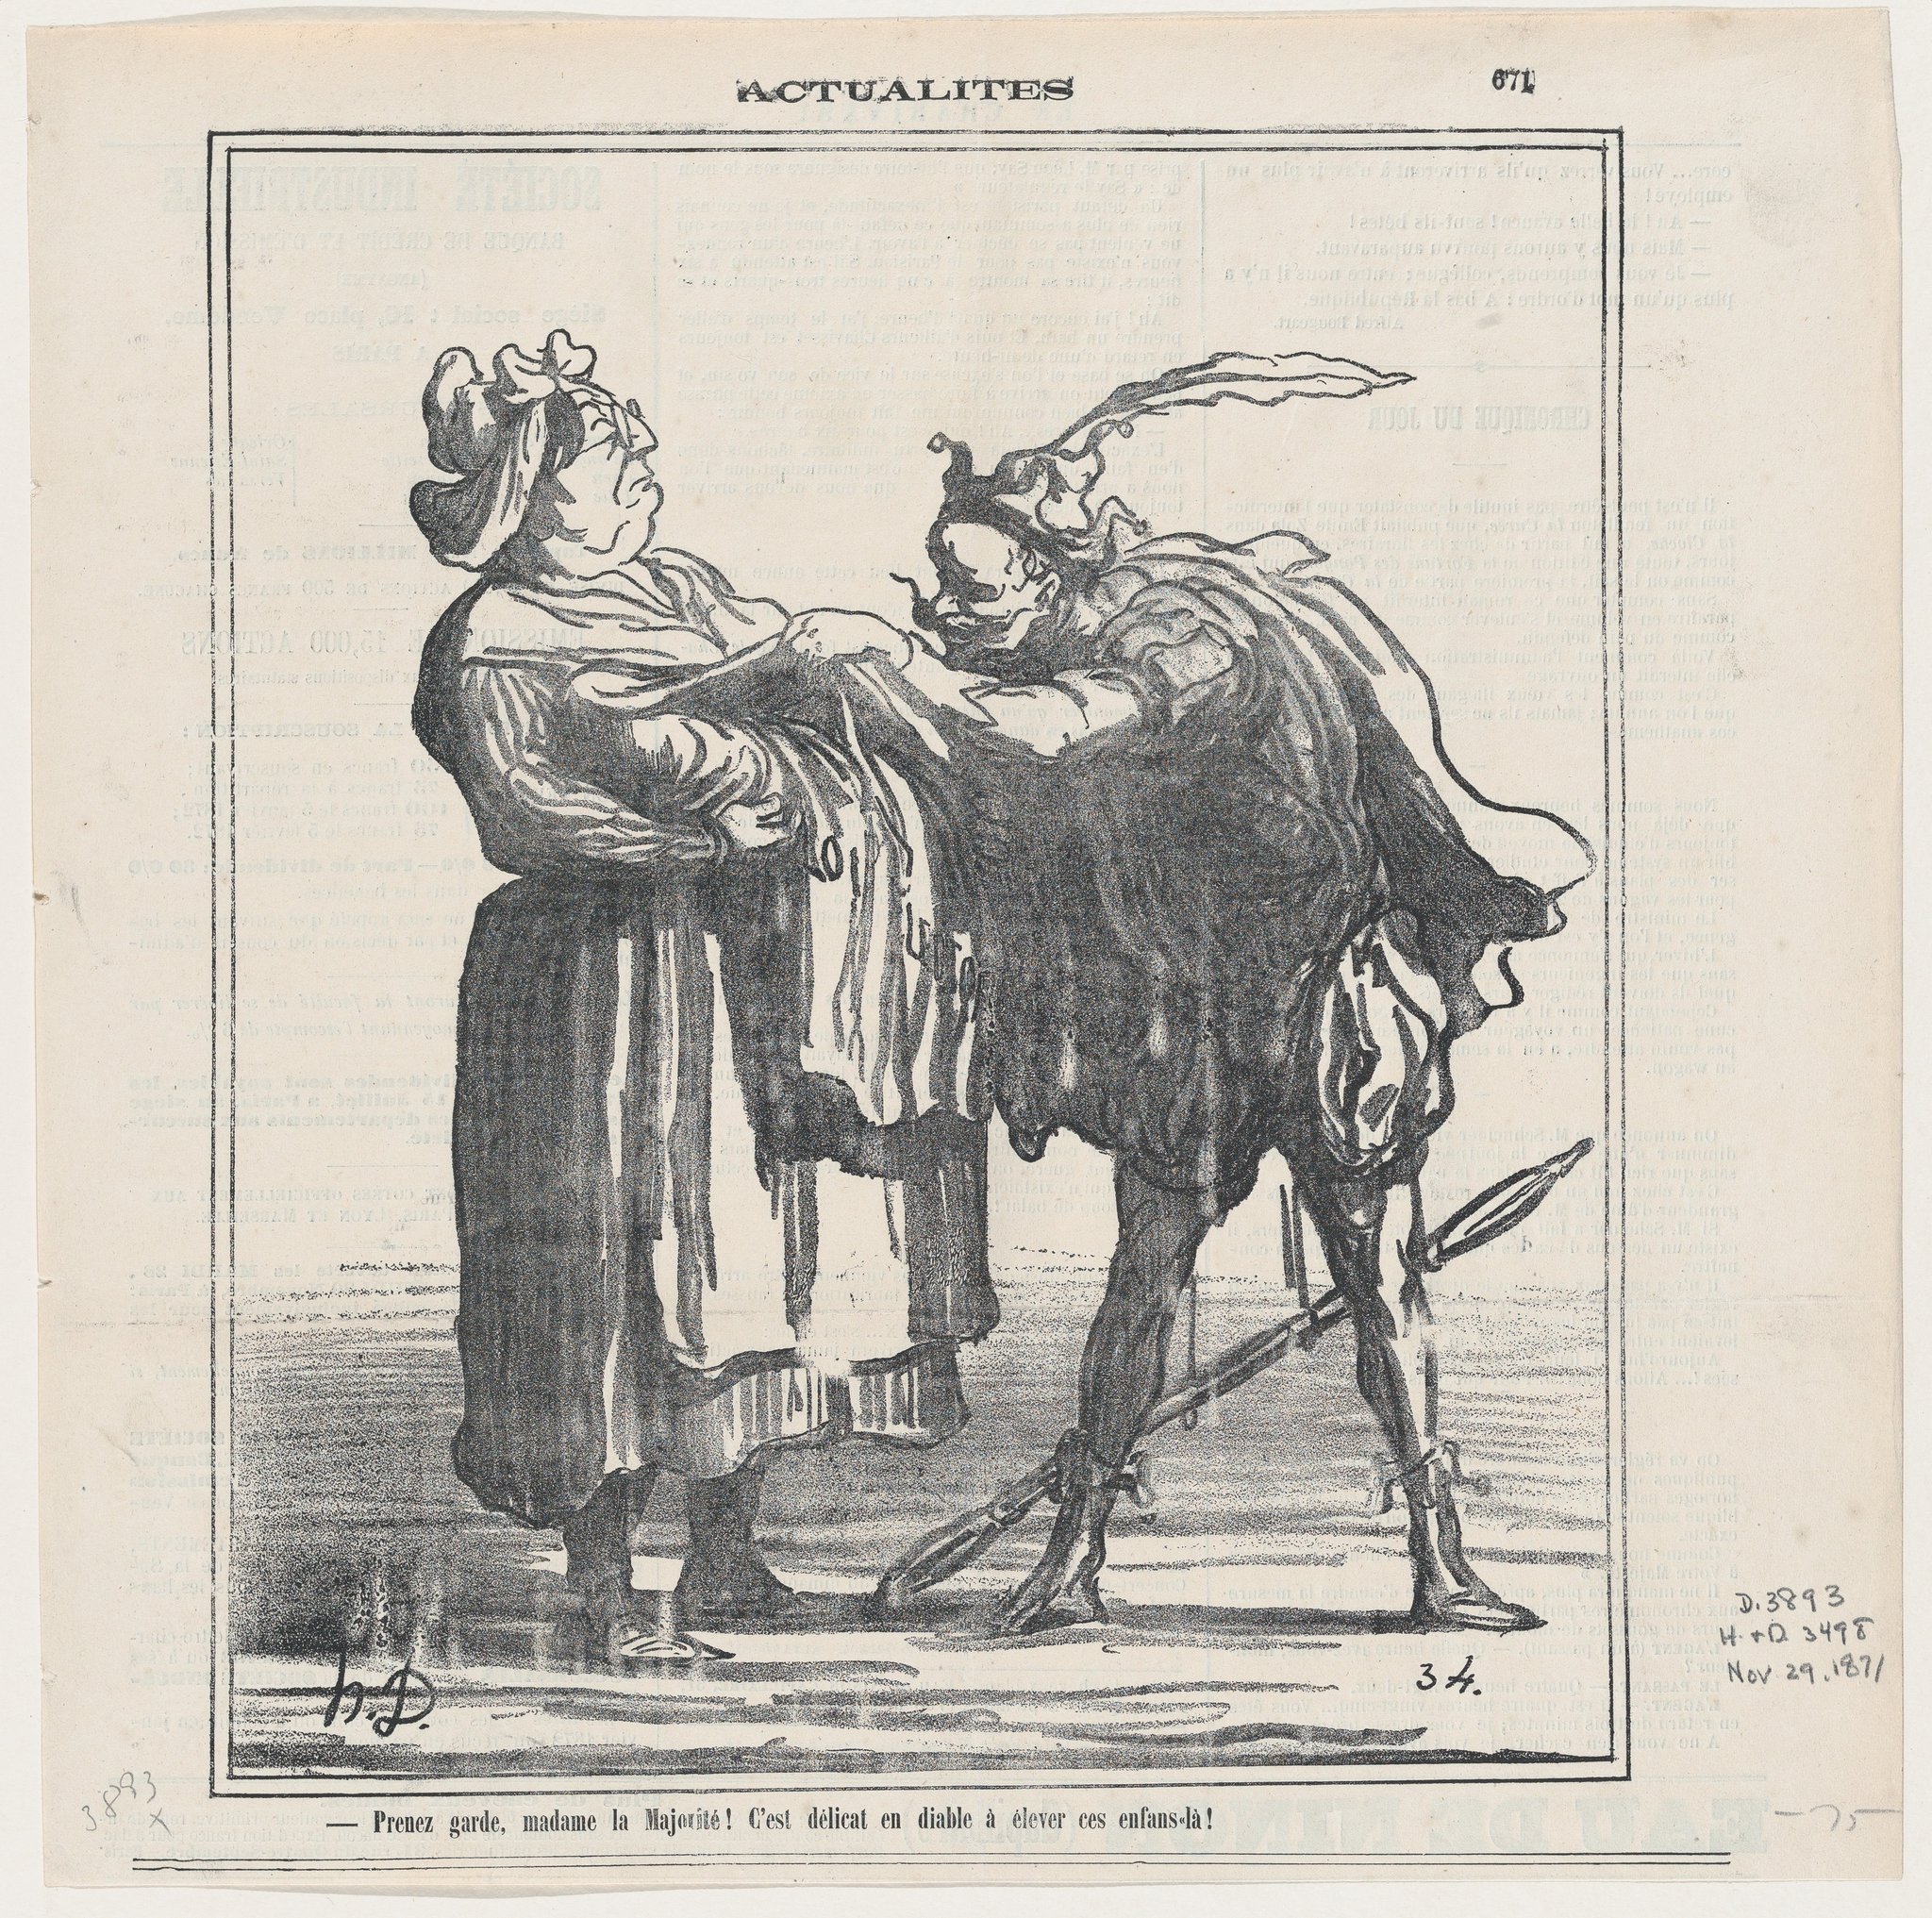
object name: print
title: Beware Madam Majority! It is devilishly delicate to raise such a child!, from 'News of the day,' published in Le Charivari, November 29, 1871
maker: honoré daumier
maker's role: artist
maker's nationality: french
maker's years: 1808-1879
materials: paper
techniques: lithograph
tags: men,women